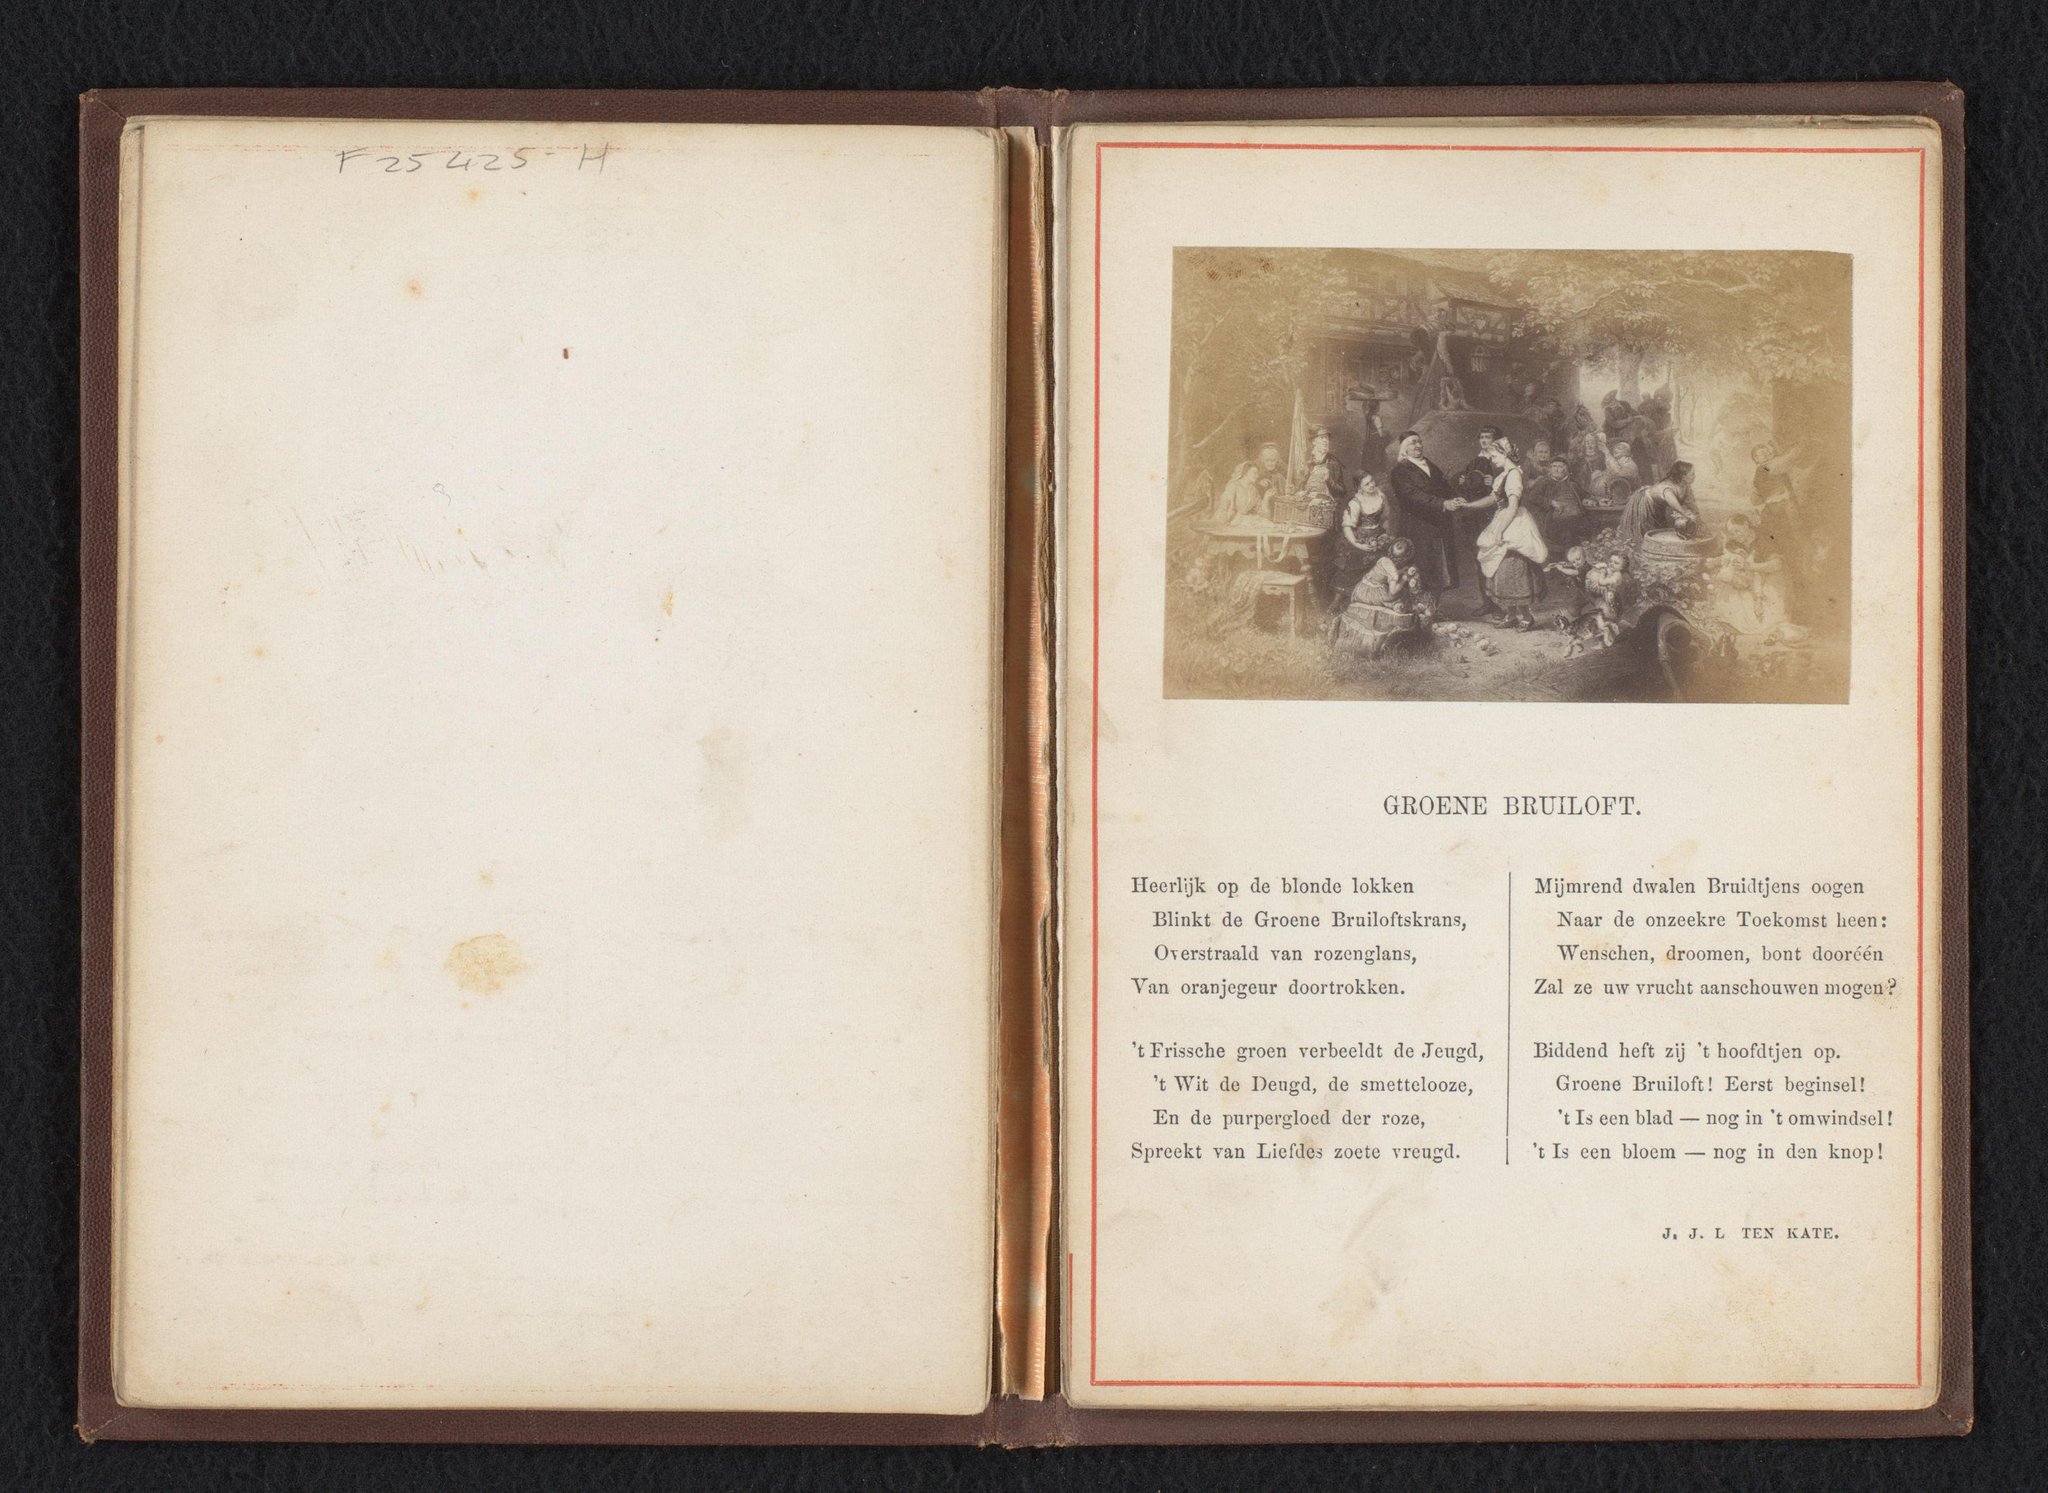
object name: reproduction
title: Fotoreproductie van het schilderij De Groene Bruiloft van Anton Heinrich Dieffenbach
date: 1866-1871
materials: cardboard, paper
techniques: albumen print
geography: amsterdam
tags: (civil) marriage ceremonies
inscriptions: inscription: ‘Heerlijk op de blonde lokken (...) J.J.L. ten Kate’